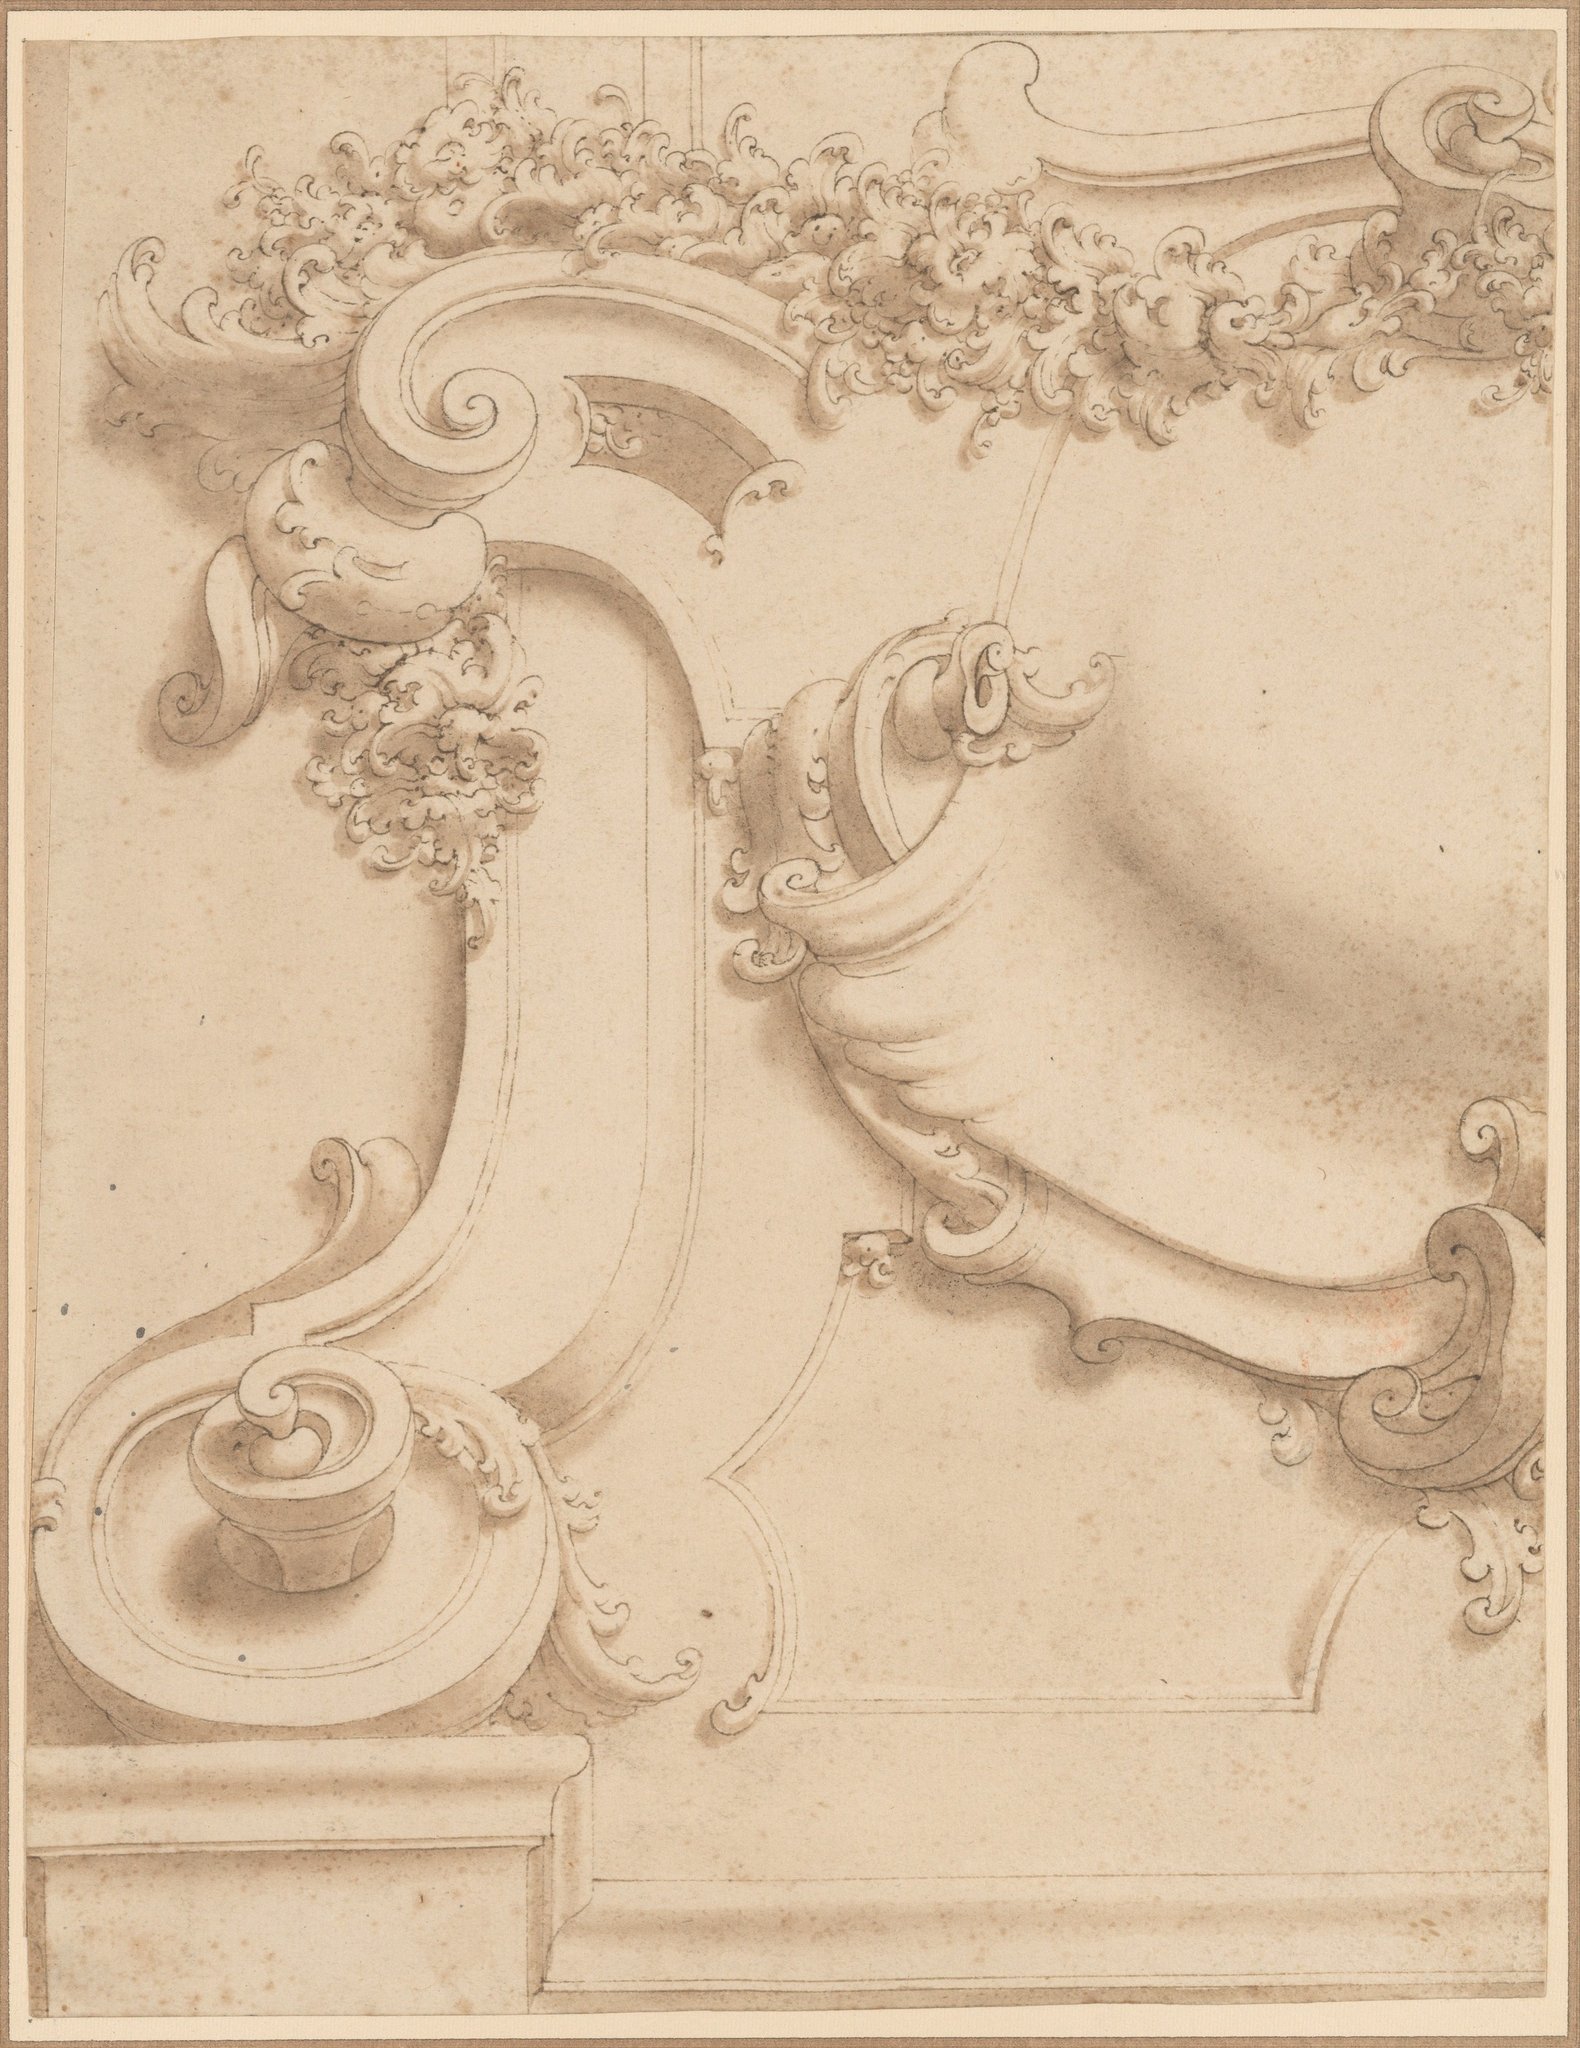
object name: drawing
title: Design for Plasterwork Cartouche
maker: anonymous, italian, 18th century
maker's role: artist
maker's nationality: italian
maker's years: 1700-1800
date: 1700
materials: ink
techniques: pen, wash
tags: cartouches